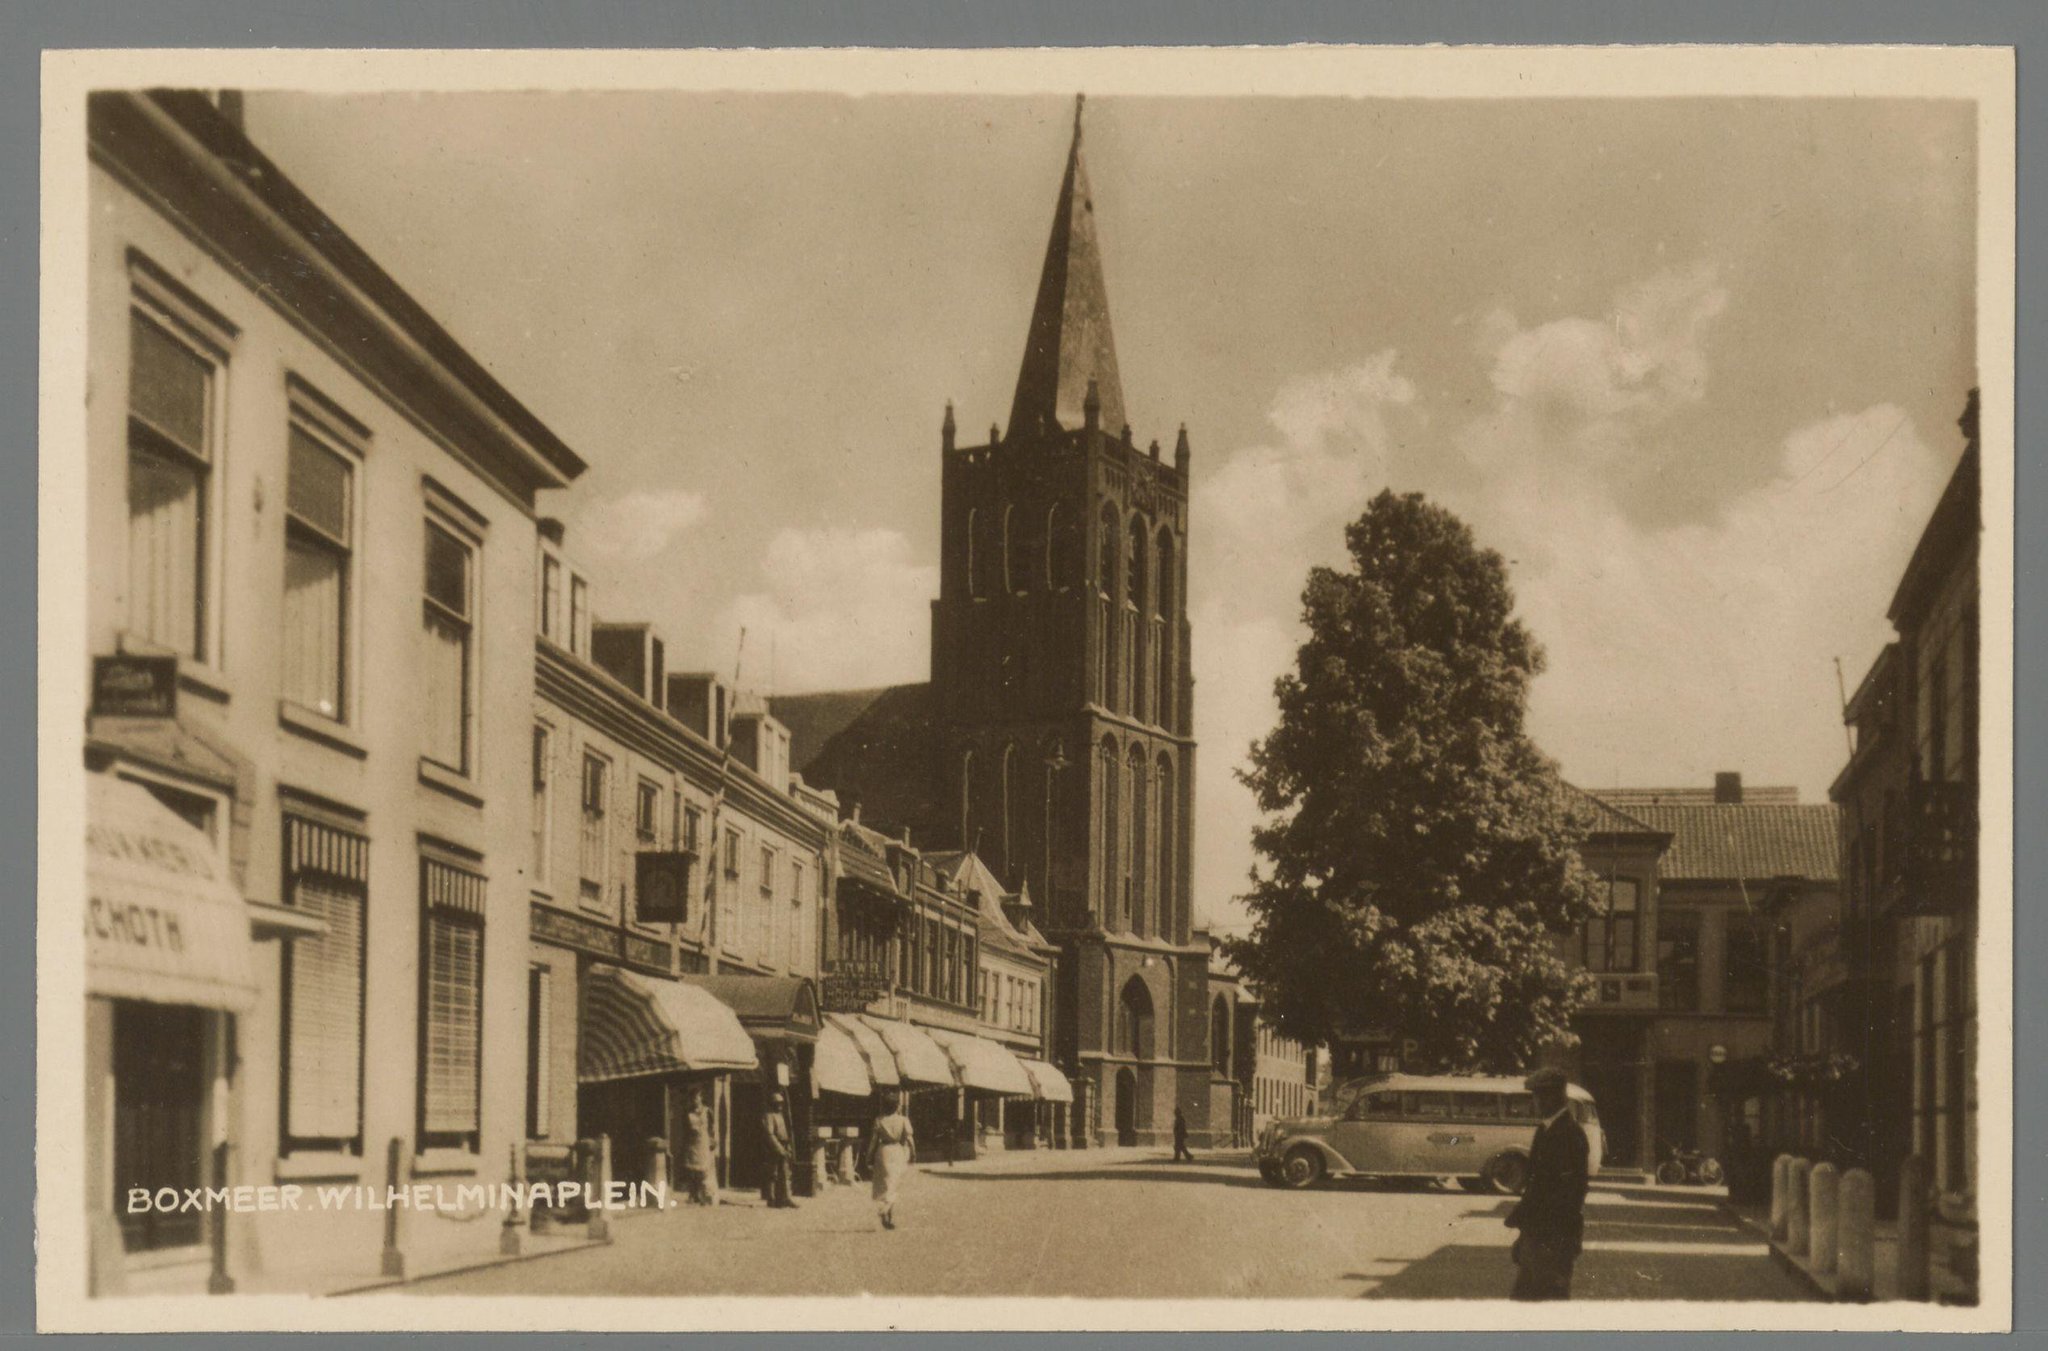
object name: photograph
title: Boxmeer. Wilhelminaplein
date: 1929-1944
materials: paper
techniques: gelatin silver print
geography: boxmeer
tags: church (exterior), street, boxmeer